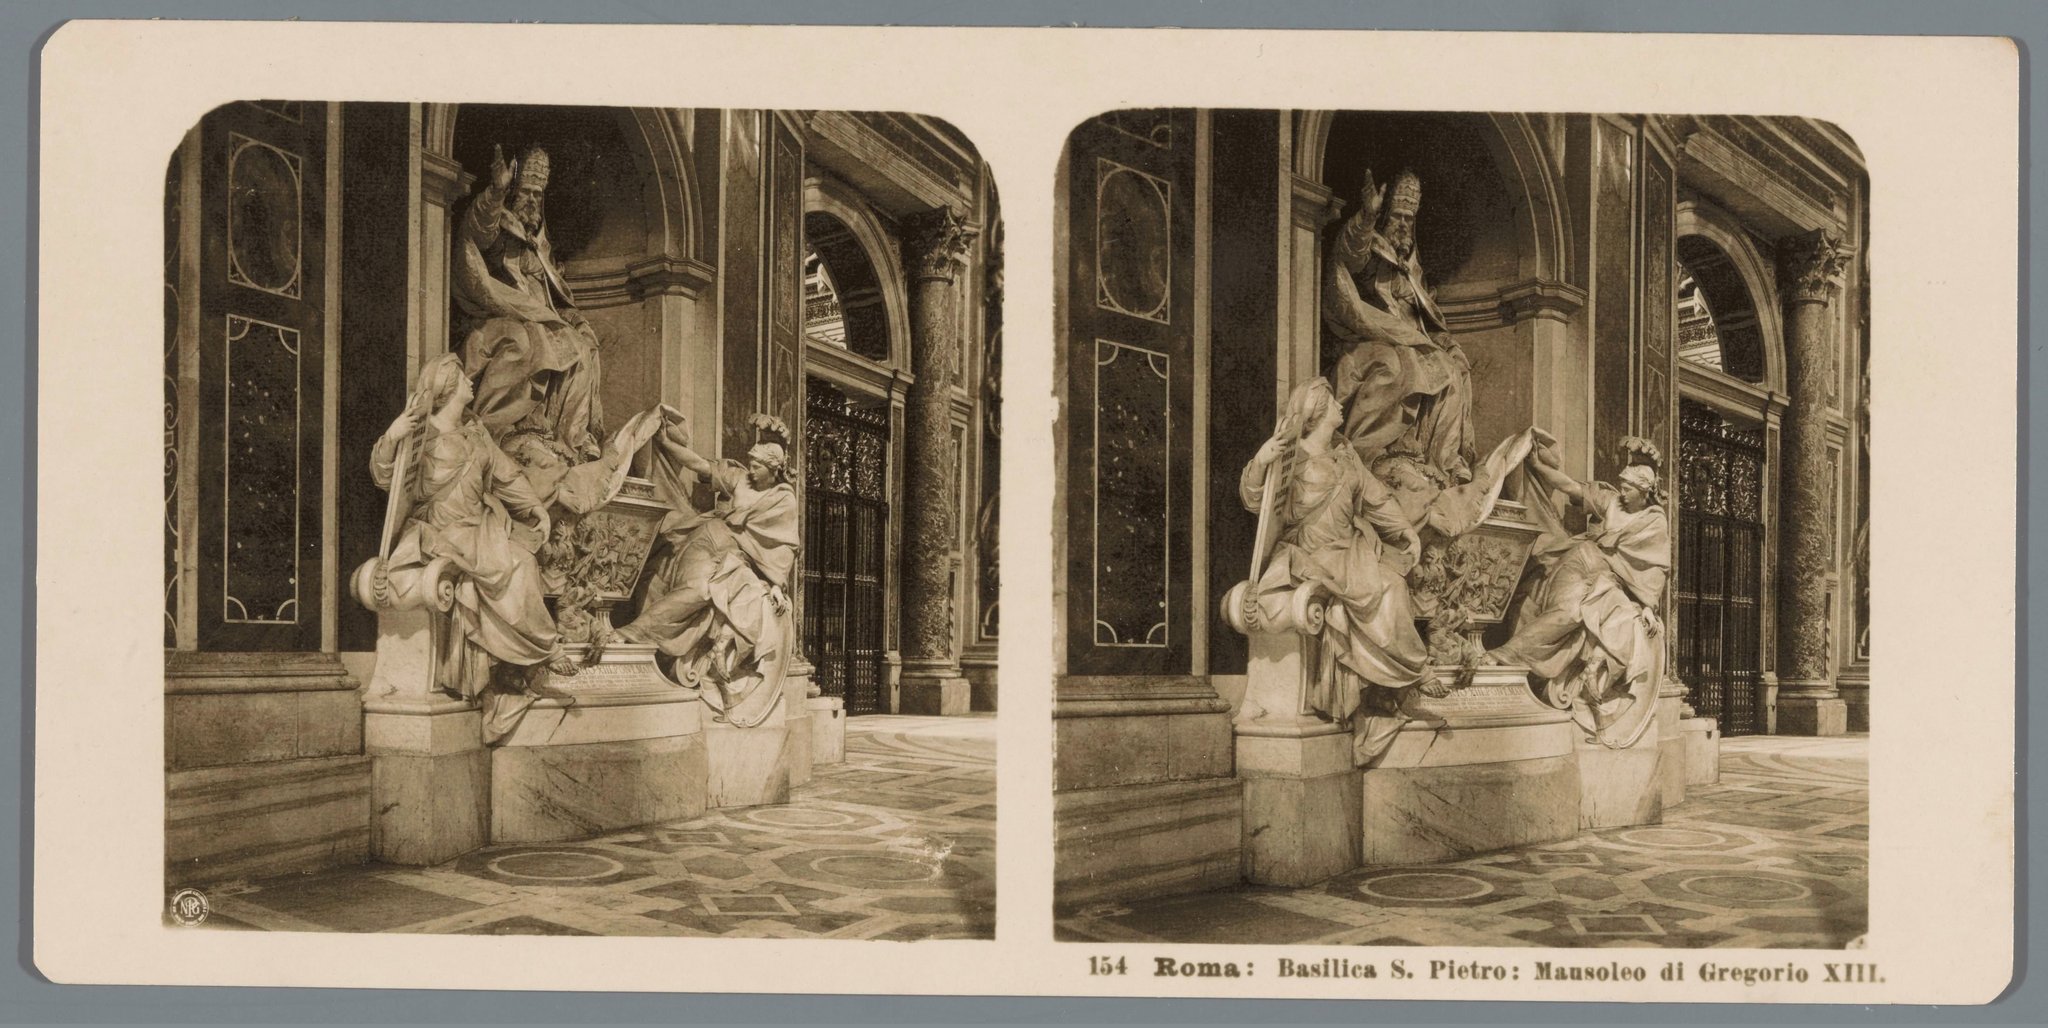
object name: stereograph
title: Graf van paus Gregorius XIII in de Sint-Pietersbasiliek te Vaticaanstad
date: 1900-1910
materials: cardboard, photographic support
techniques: gelatin silver print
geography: sint-pietersbasiliek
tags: grave, tomb, interior of church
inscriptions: number: ‘154’, inscription: ‘NPG’